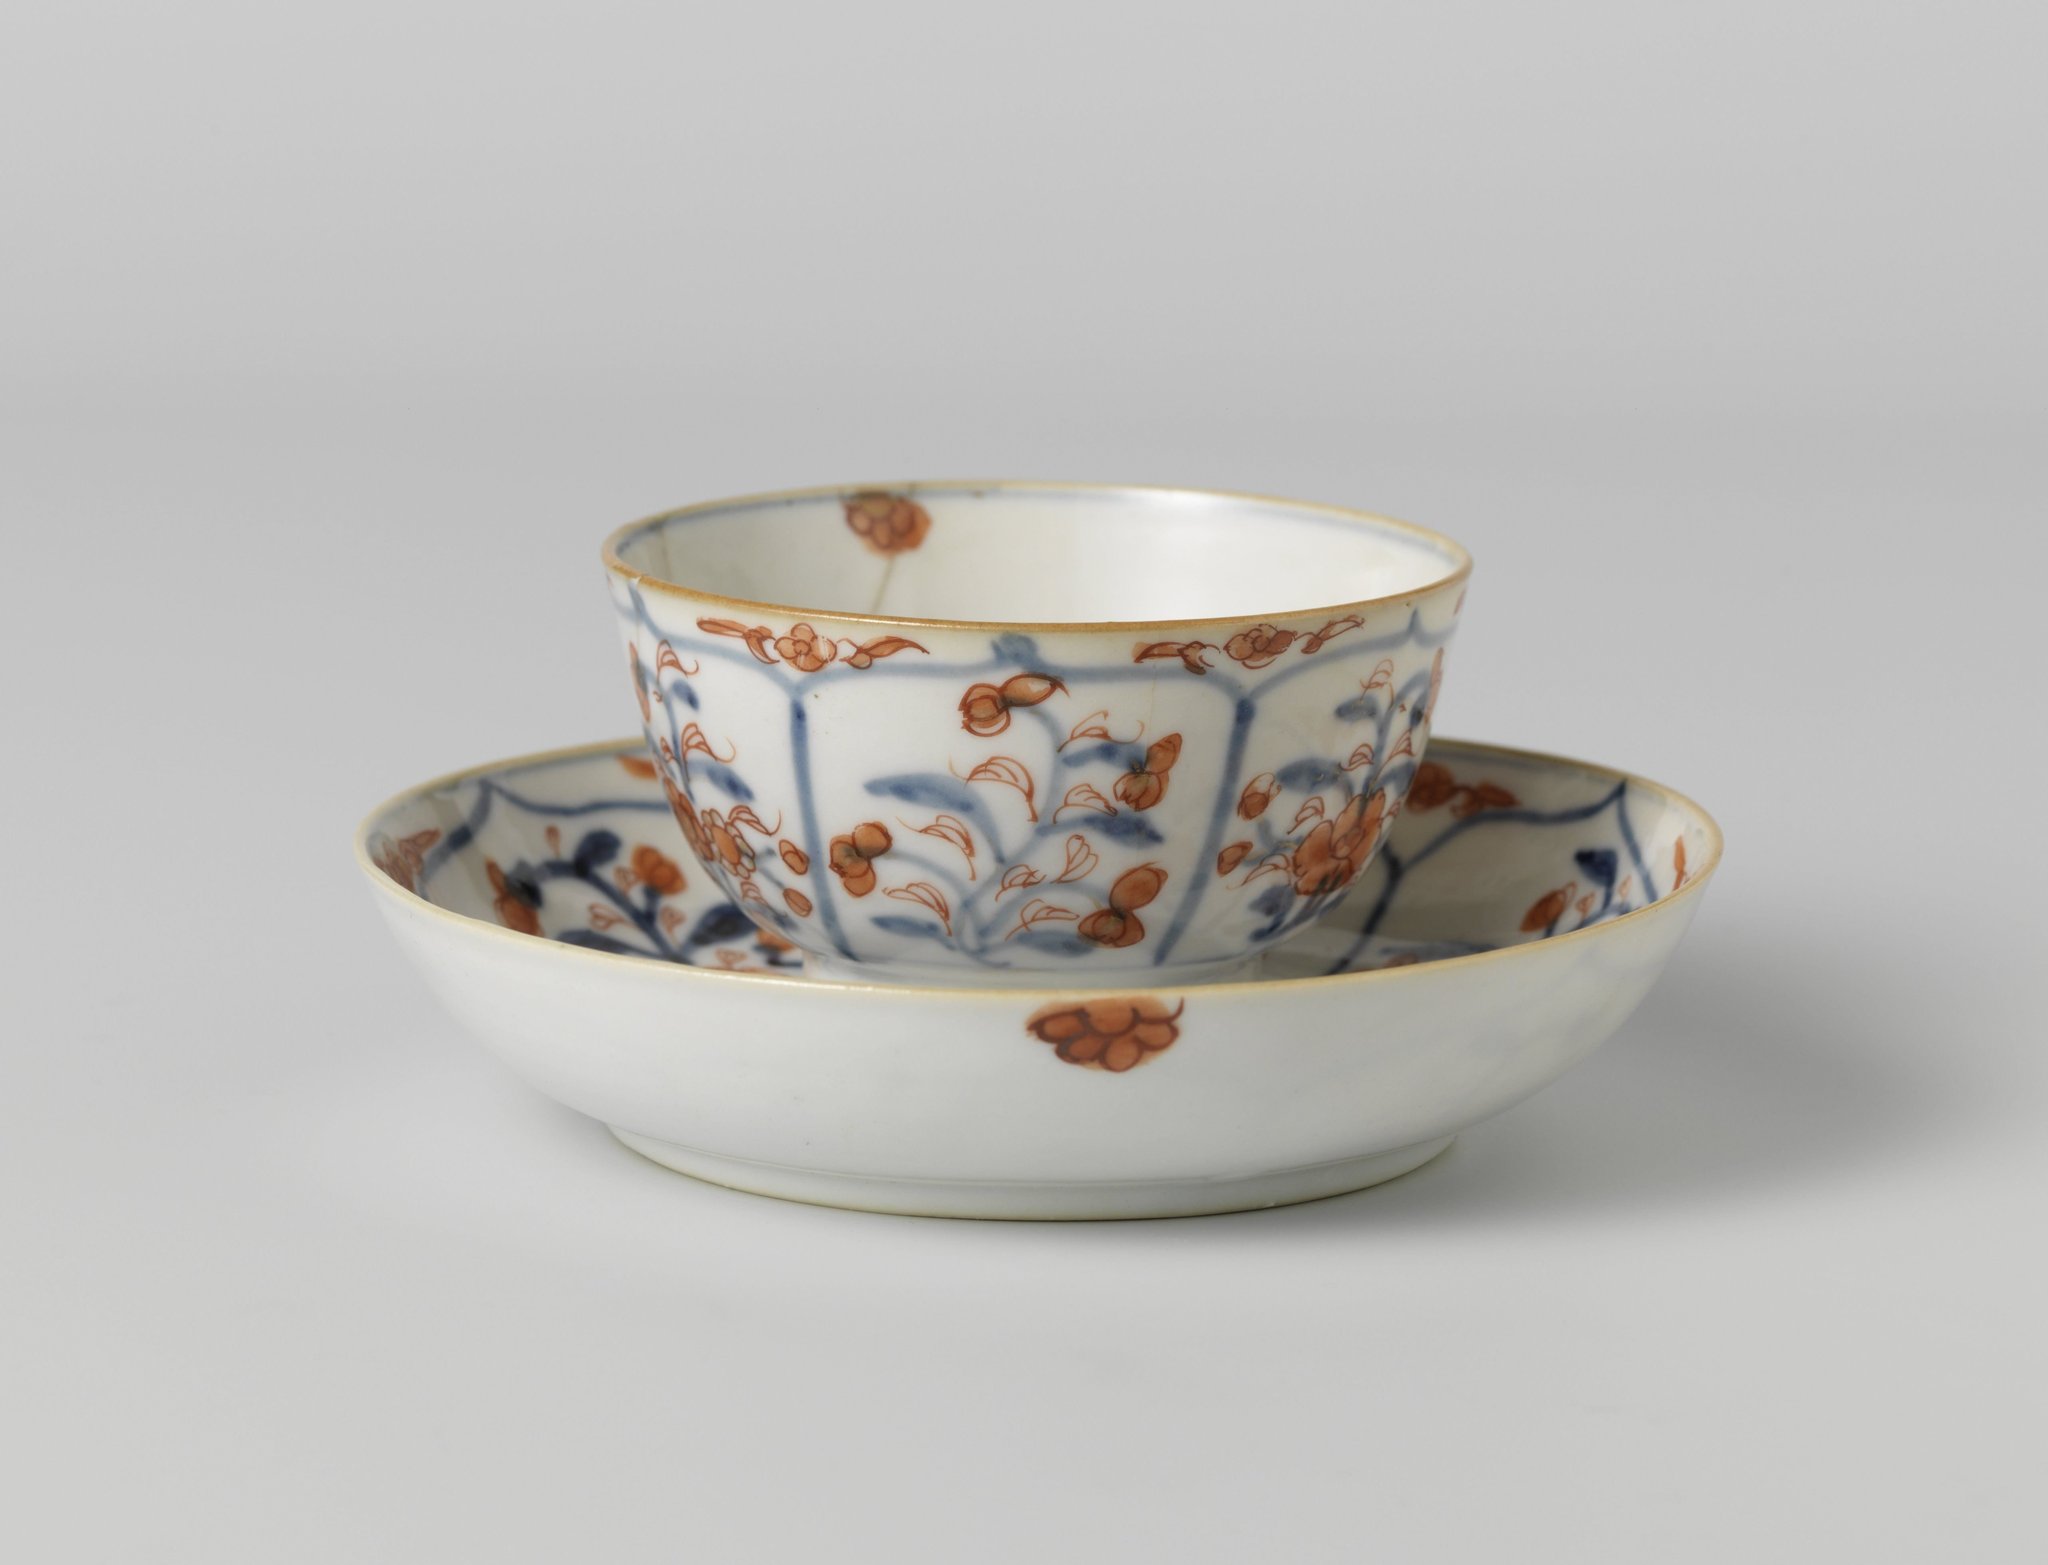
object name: kop en schotel, kop en schotel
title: Cup and saucer with petal-shaped panel around a central medallion, filled with flower sprays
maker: Anonymous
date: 1750-1774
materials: cobalt, glaze, gold, paint, porcelain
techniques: firing, gilding, turning, vitrification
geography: china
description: Beschilderd met vakken waarin takjes in blauw, rood en goud.